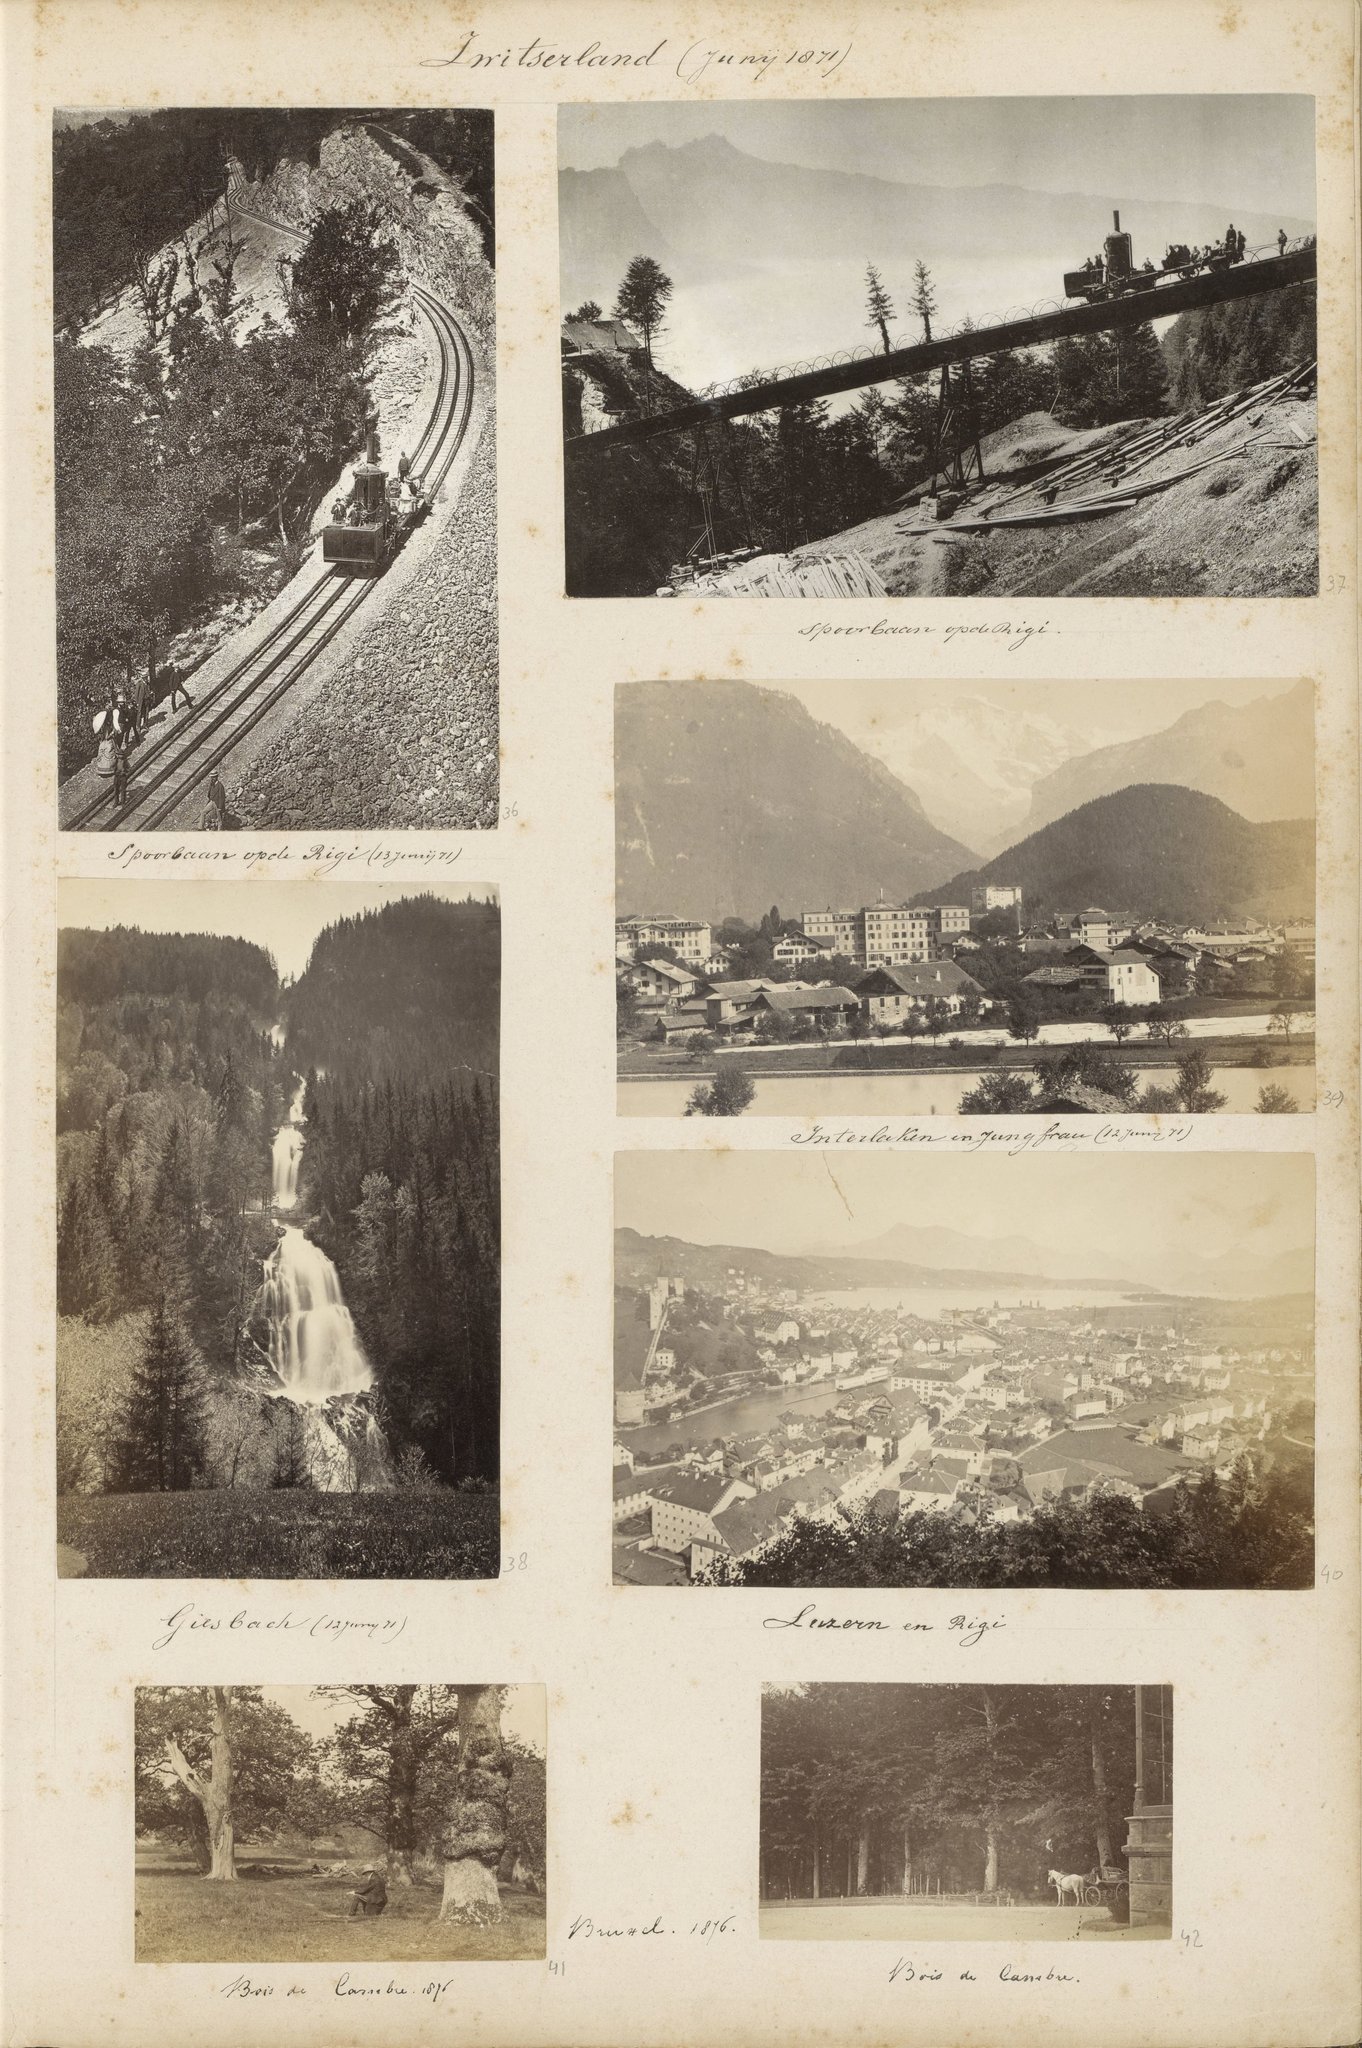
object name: photograph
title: Treinstel en reizigers op de Rigispoorbaan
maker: Anonymous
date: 1806-1871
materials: paper, photographic support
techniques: photograph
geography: lucerne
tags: funicular railway, travelling; tourism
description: Onderdeel van Fotoalbum van Robert Daniel Crommelin (1841-1907).